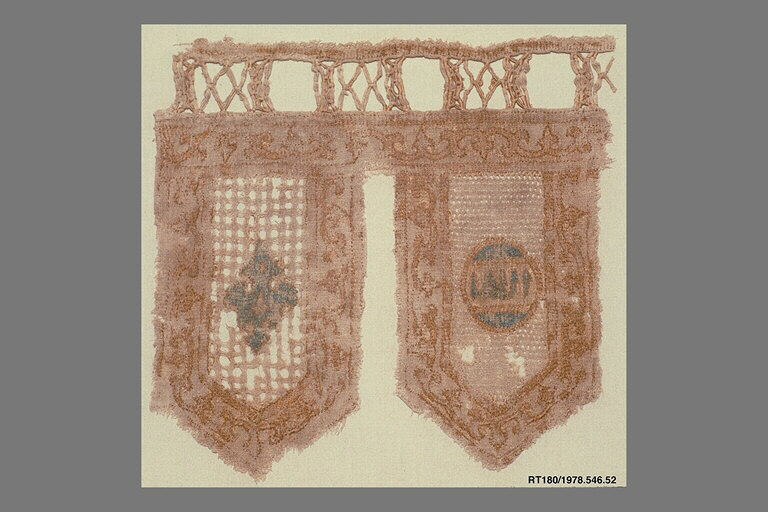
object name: textile fragment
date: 1301-1400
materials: linen, silk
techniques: embroidery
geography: egypt